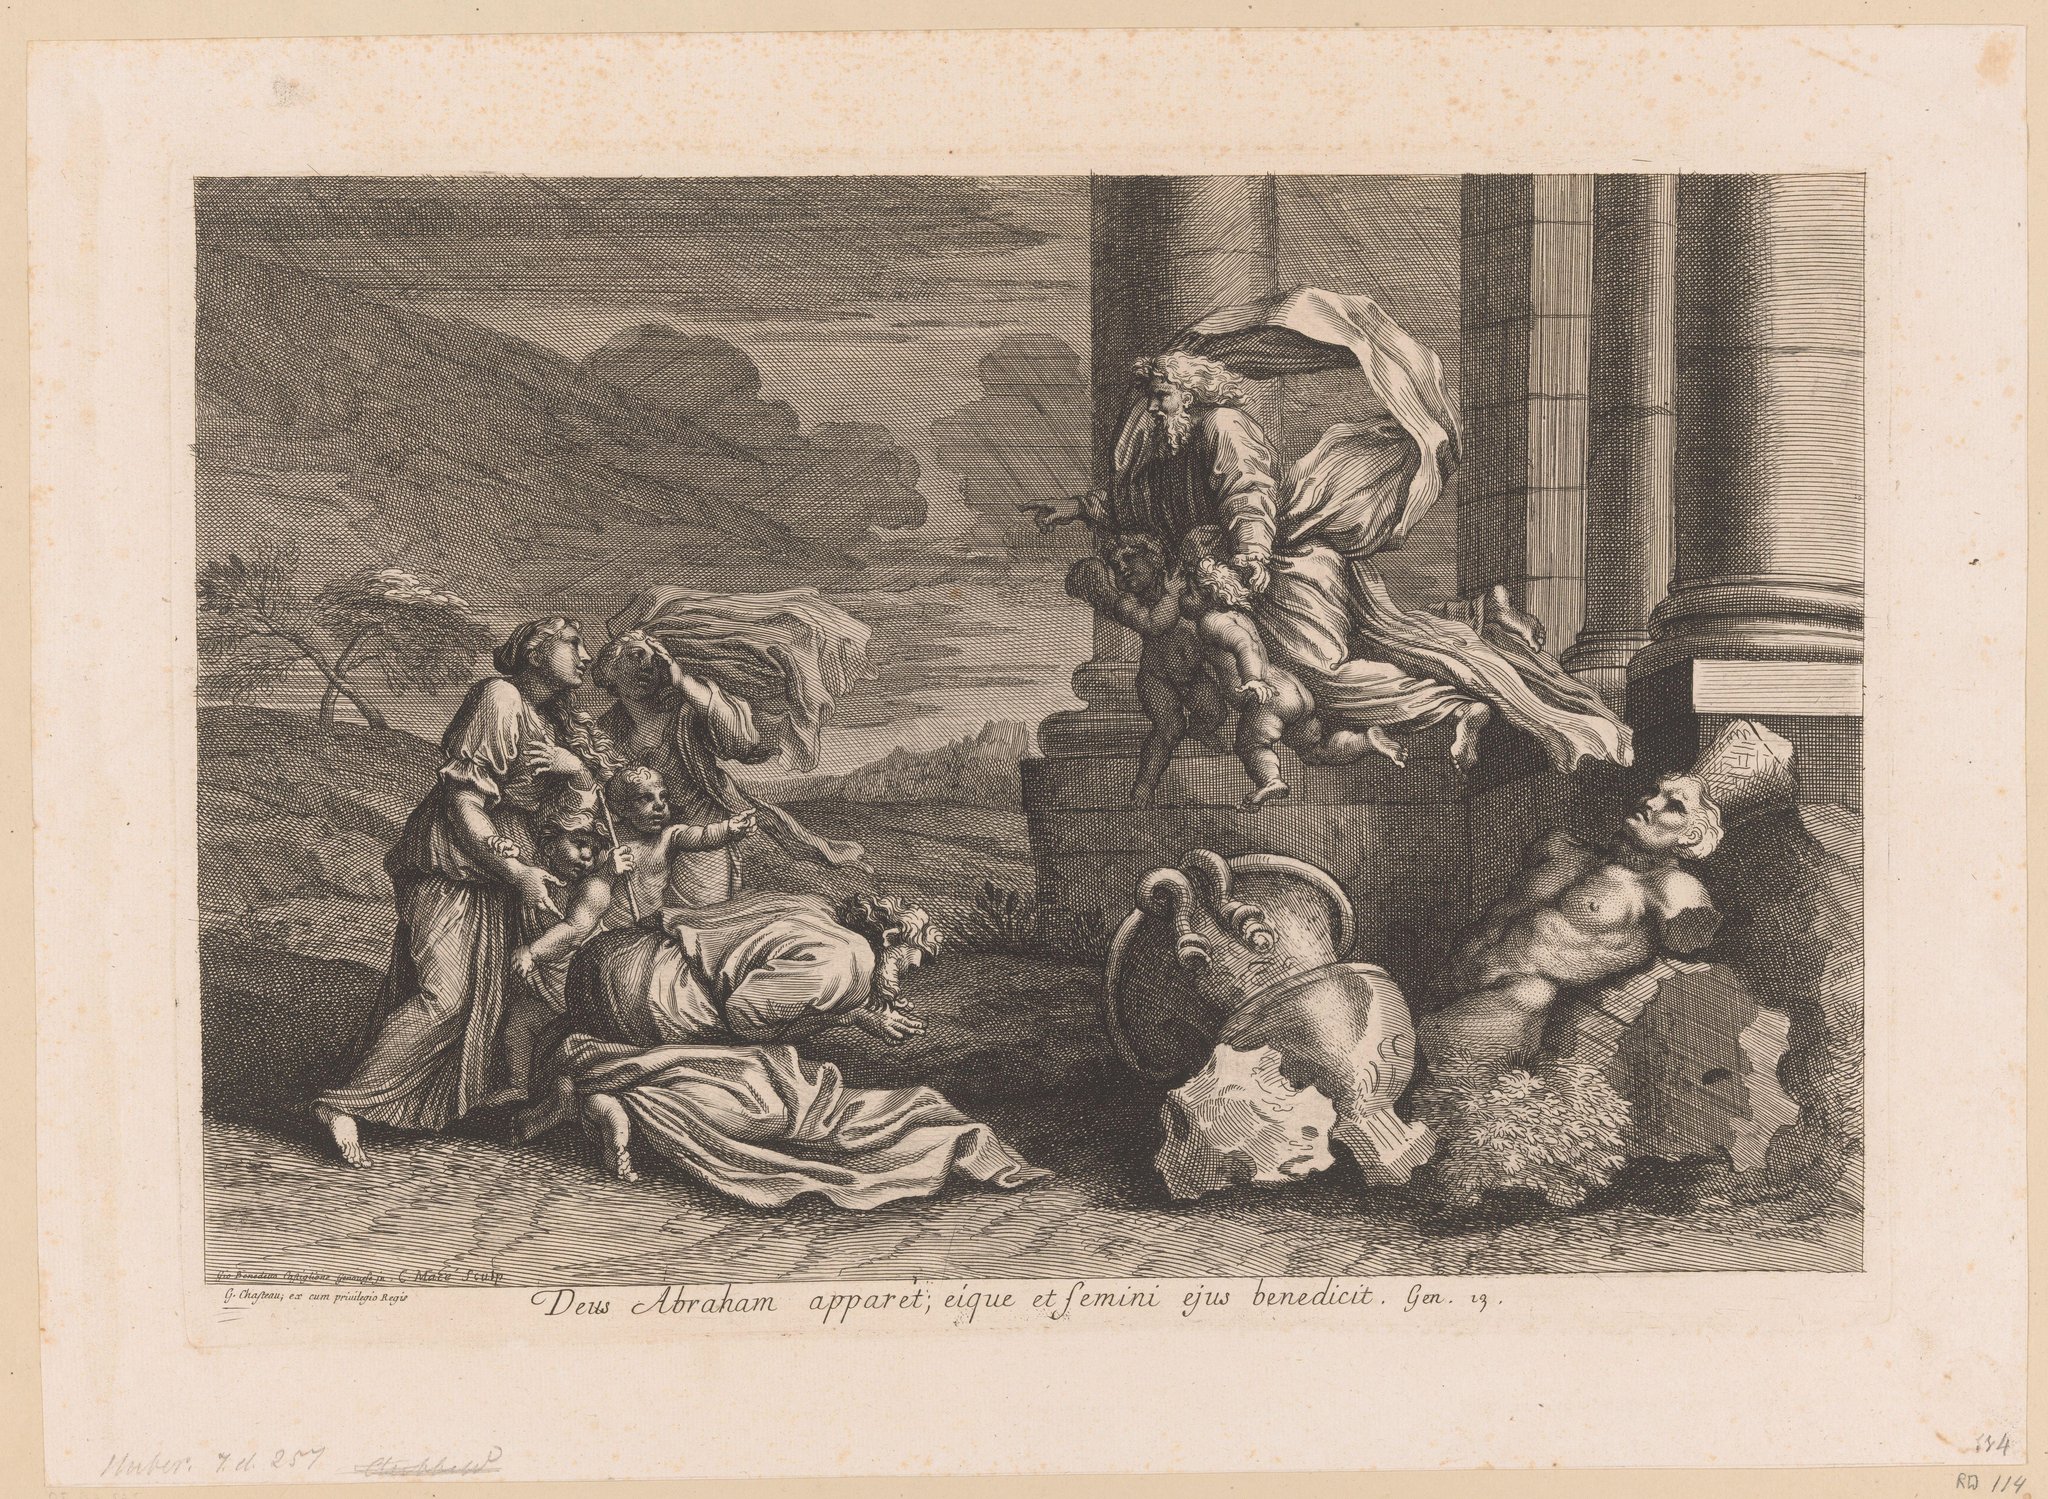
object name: print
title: Zegening van Abraham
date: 1641-1665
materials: paper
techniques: engraving, etching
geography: france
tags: melchizedek blesses abraham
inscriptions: collector's mark: Lugt 240